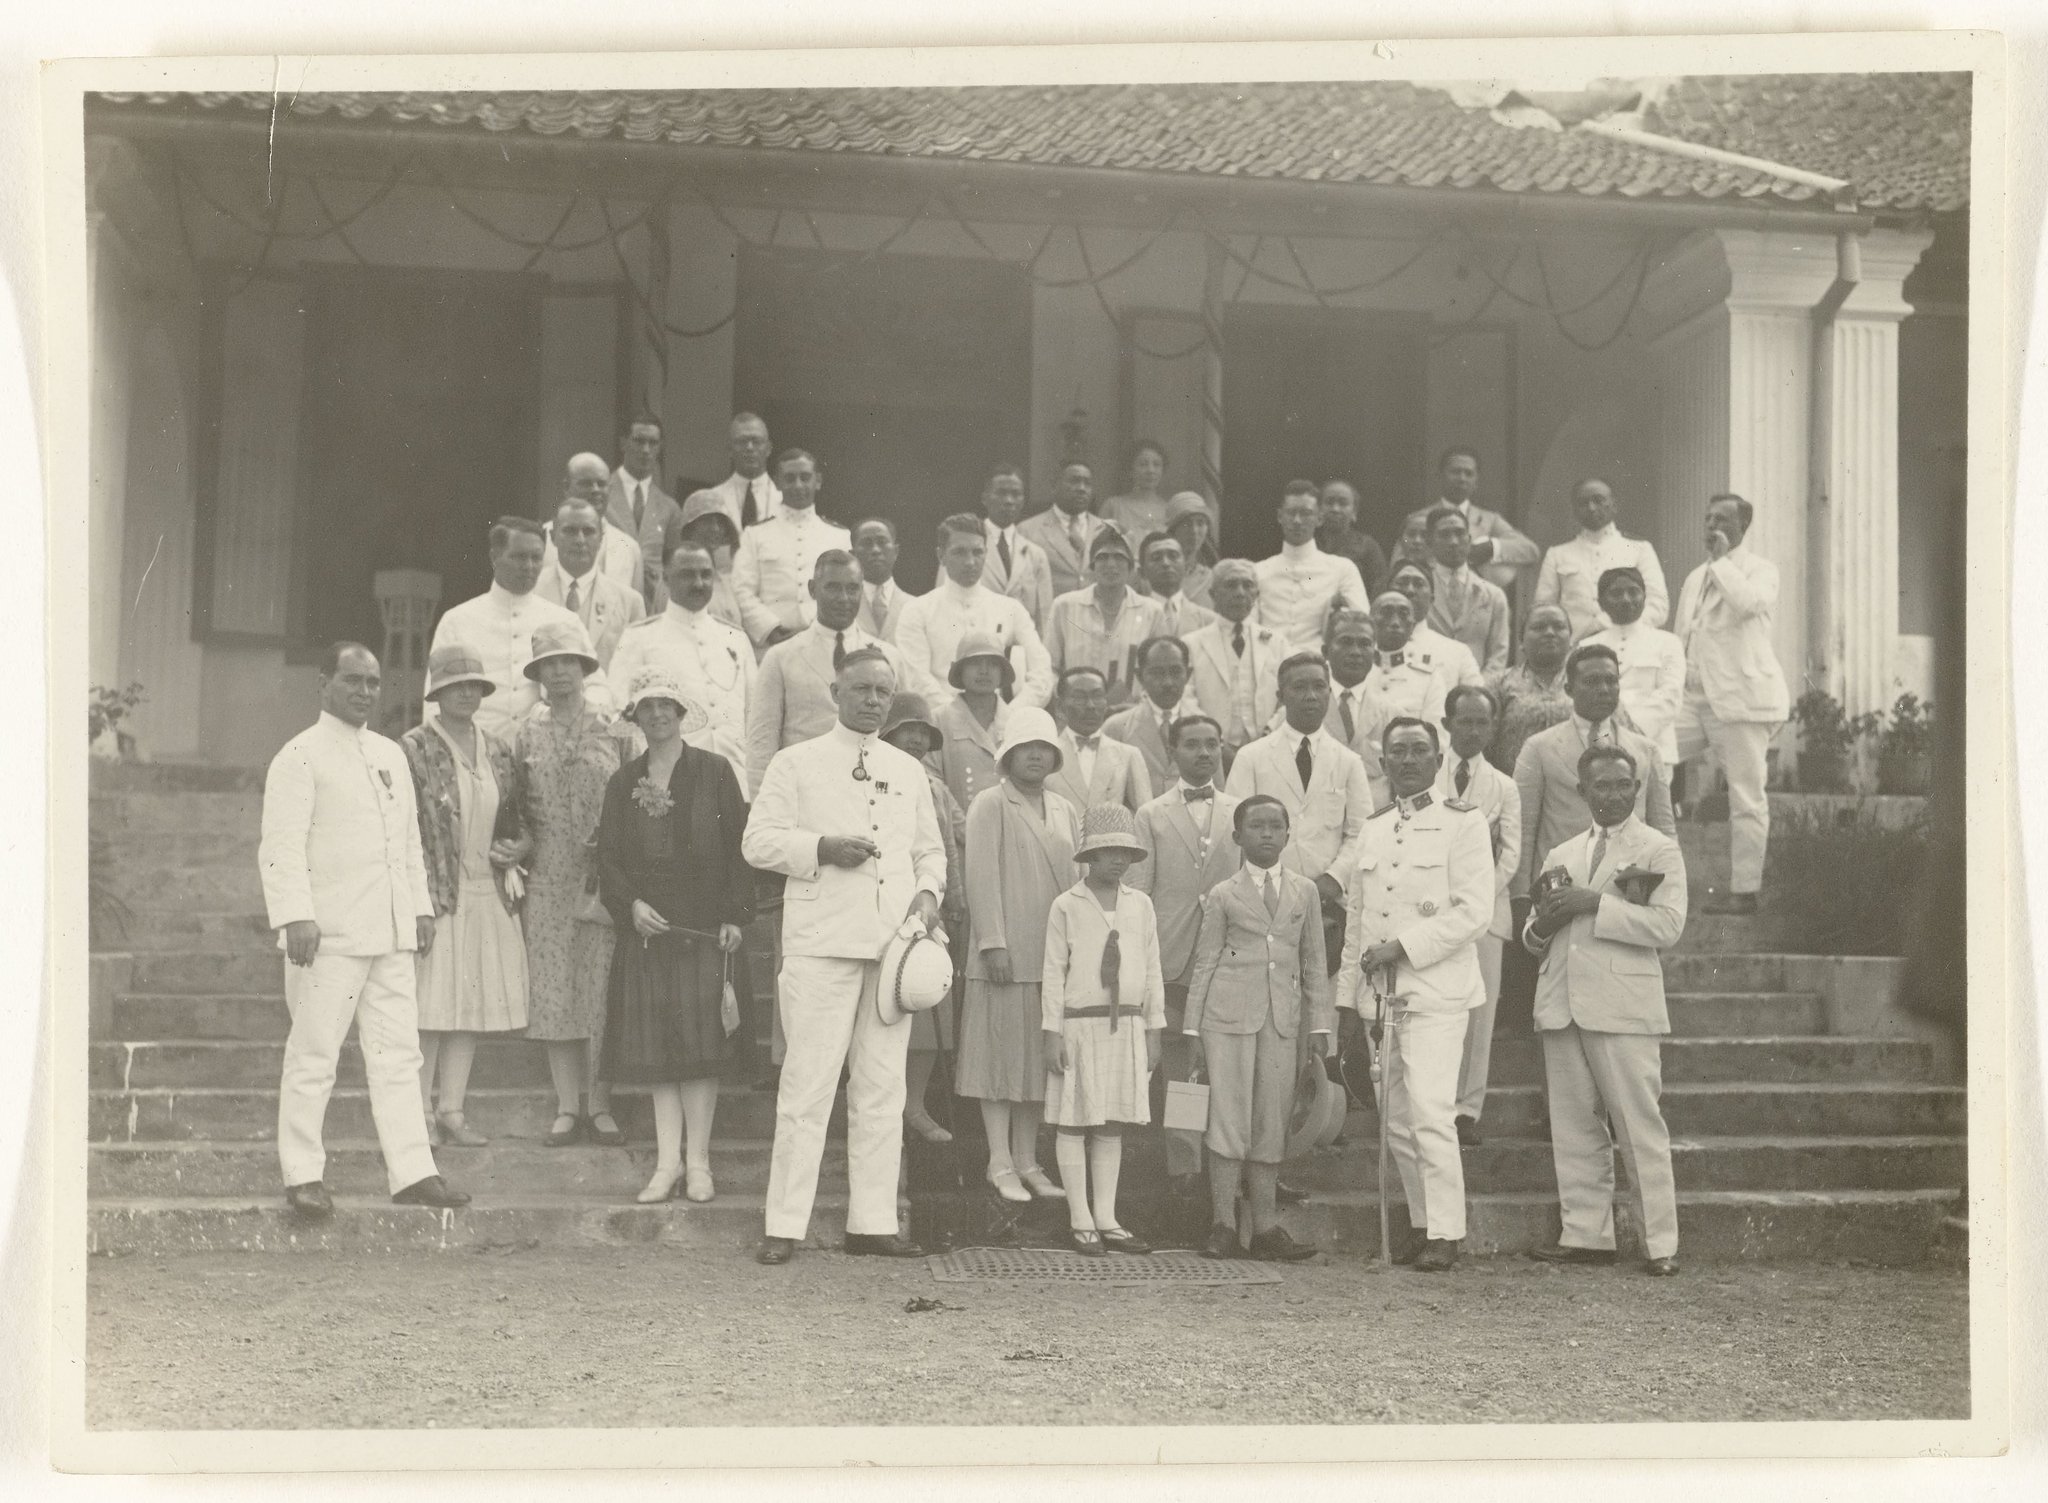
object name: photograph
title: Bezoek van de koning van Siam aan een hotel in Solo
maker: Anonymous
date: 1929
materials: photographic support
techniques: photography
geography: solo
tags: solo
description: Bezoek van de koning van Siam aan een hotel in Solo.